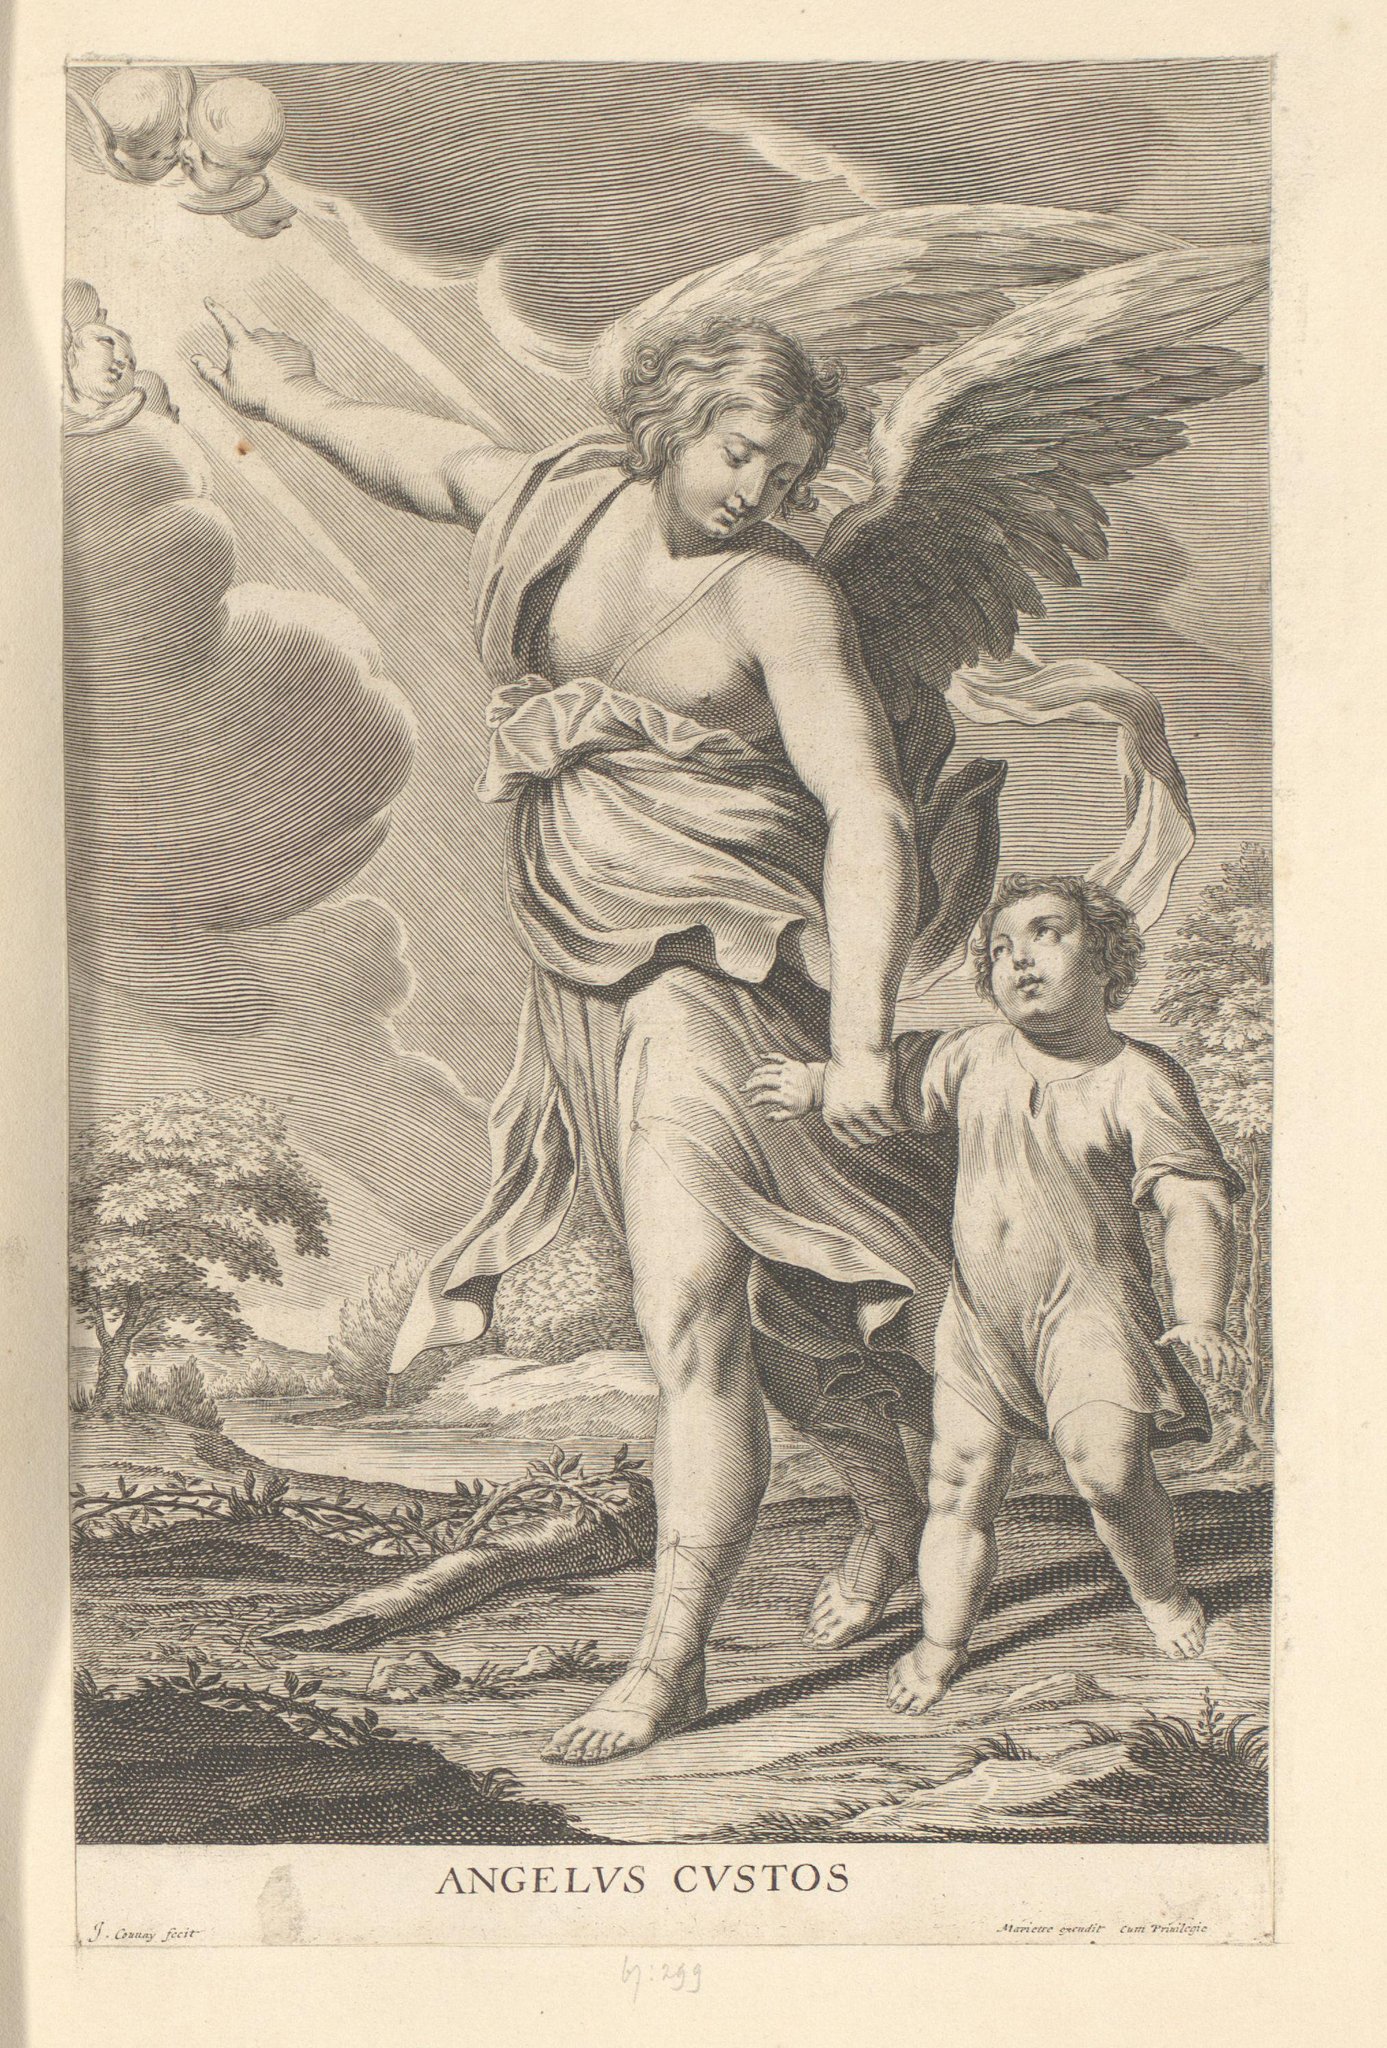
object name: print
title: Angelus custos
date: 1632-1675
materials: paper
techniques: engraving, etching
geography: paris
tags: gripping someone by the arm, guardian angel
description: Deze prent maakt deel uit van een album.